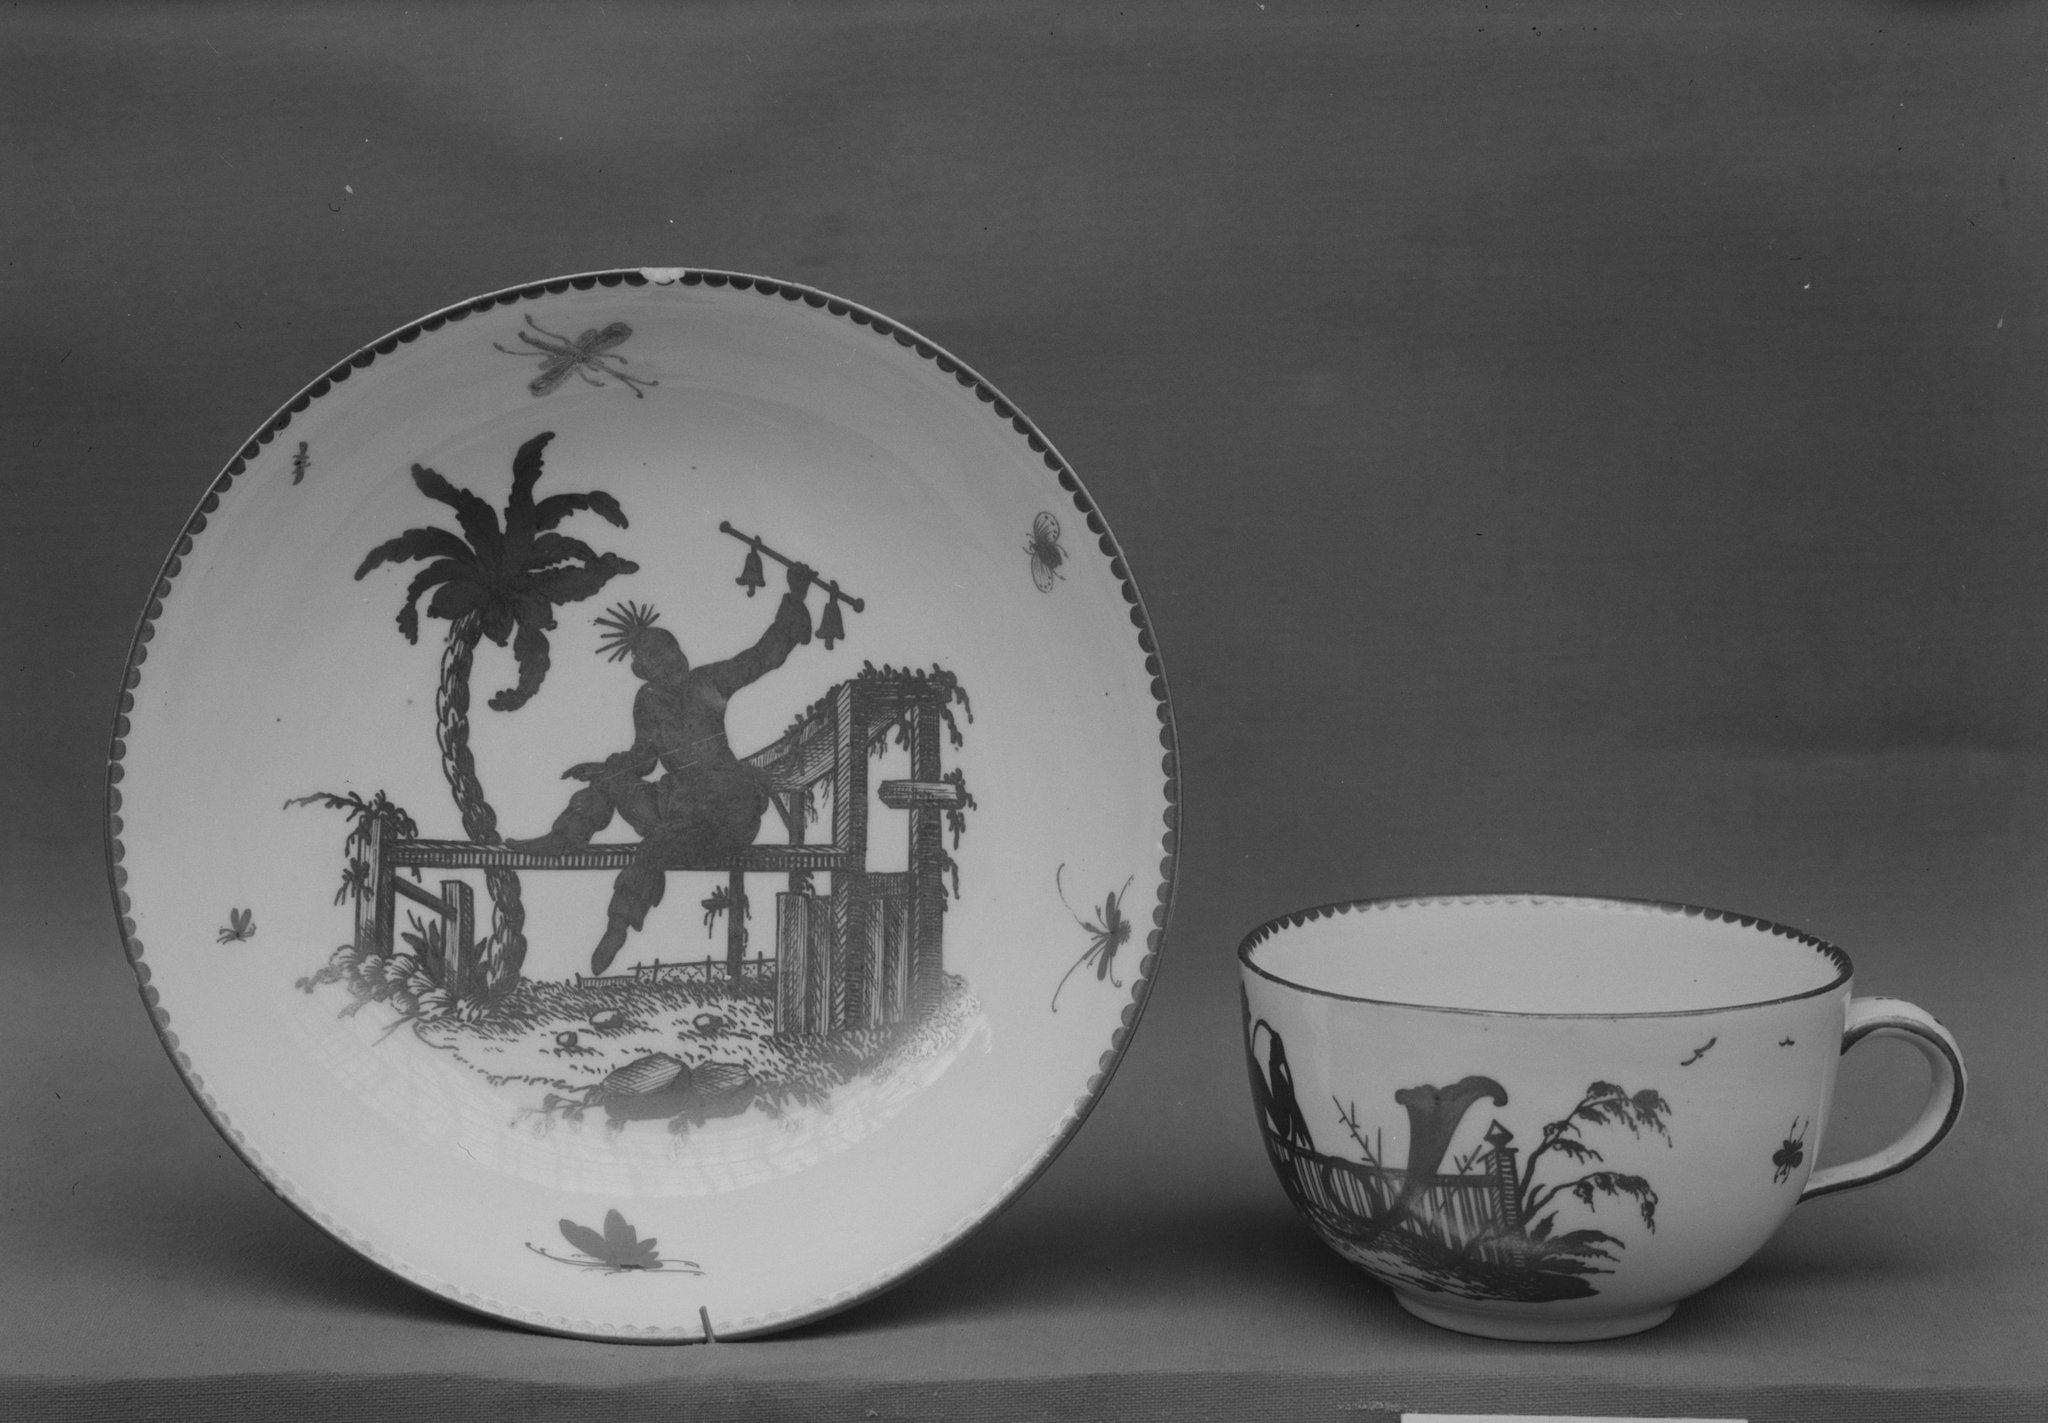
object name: cup and saucer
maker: frankenthal porcelain manufactory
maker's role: manufactory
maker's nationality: german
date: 1771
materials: hard paste porcelain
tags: human figures,insects,trees